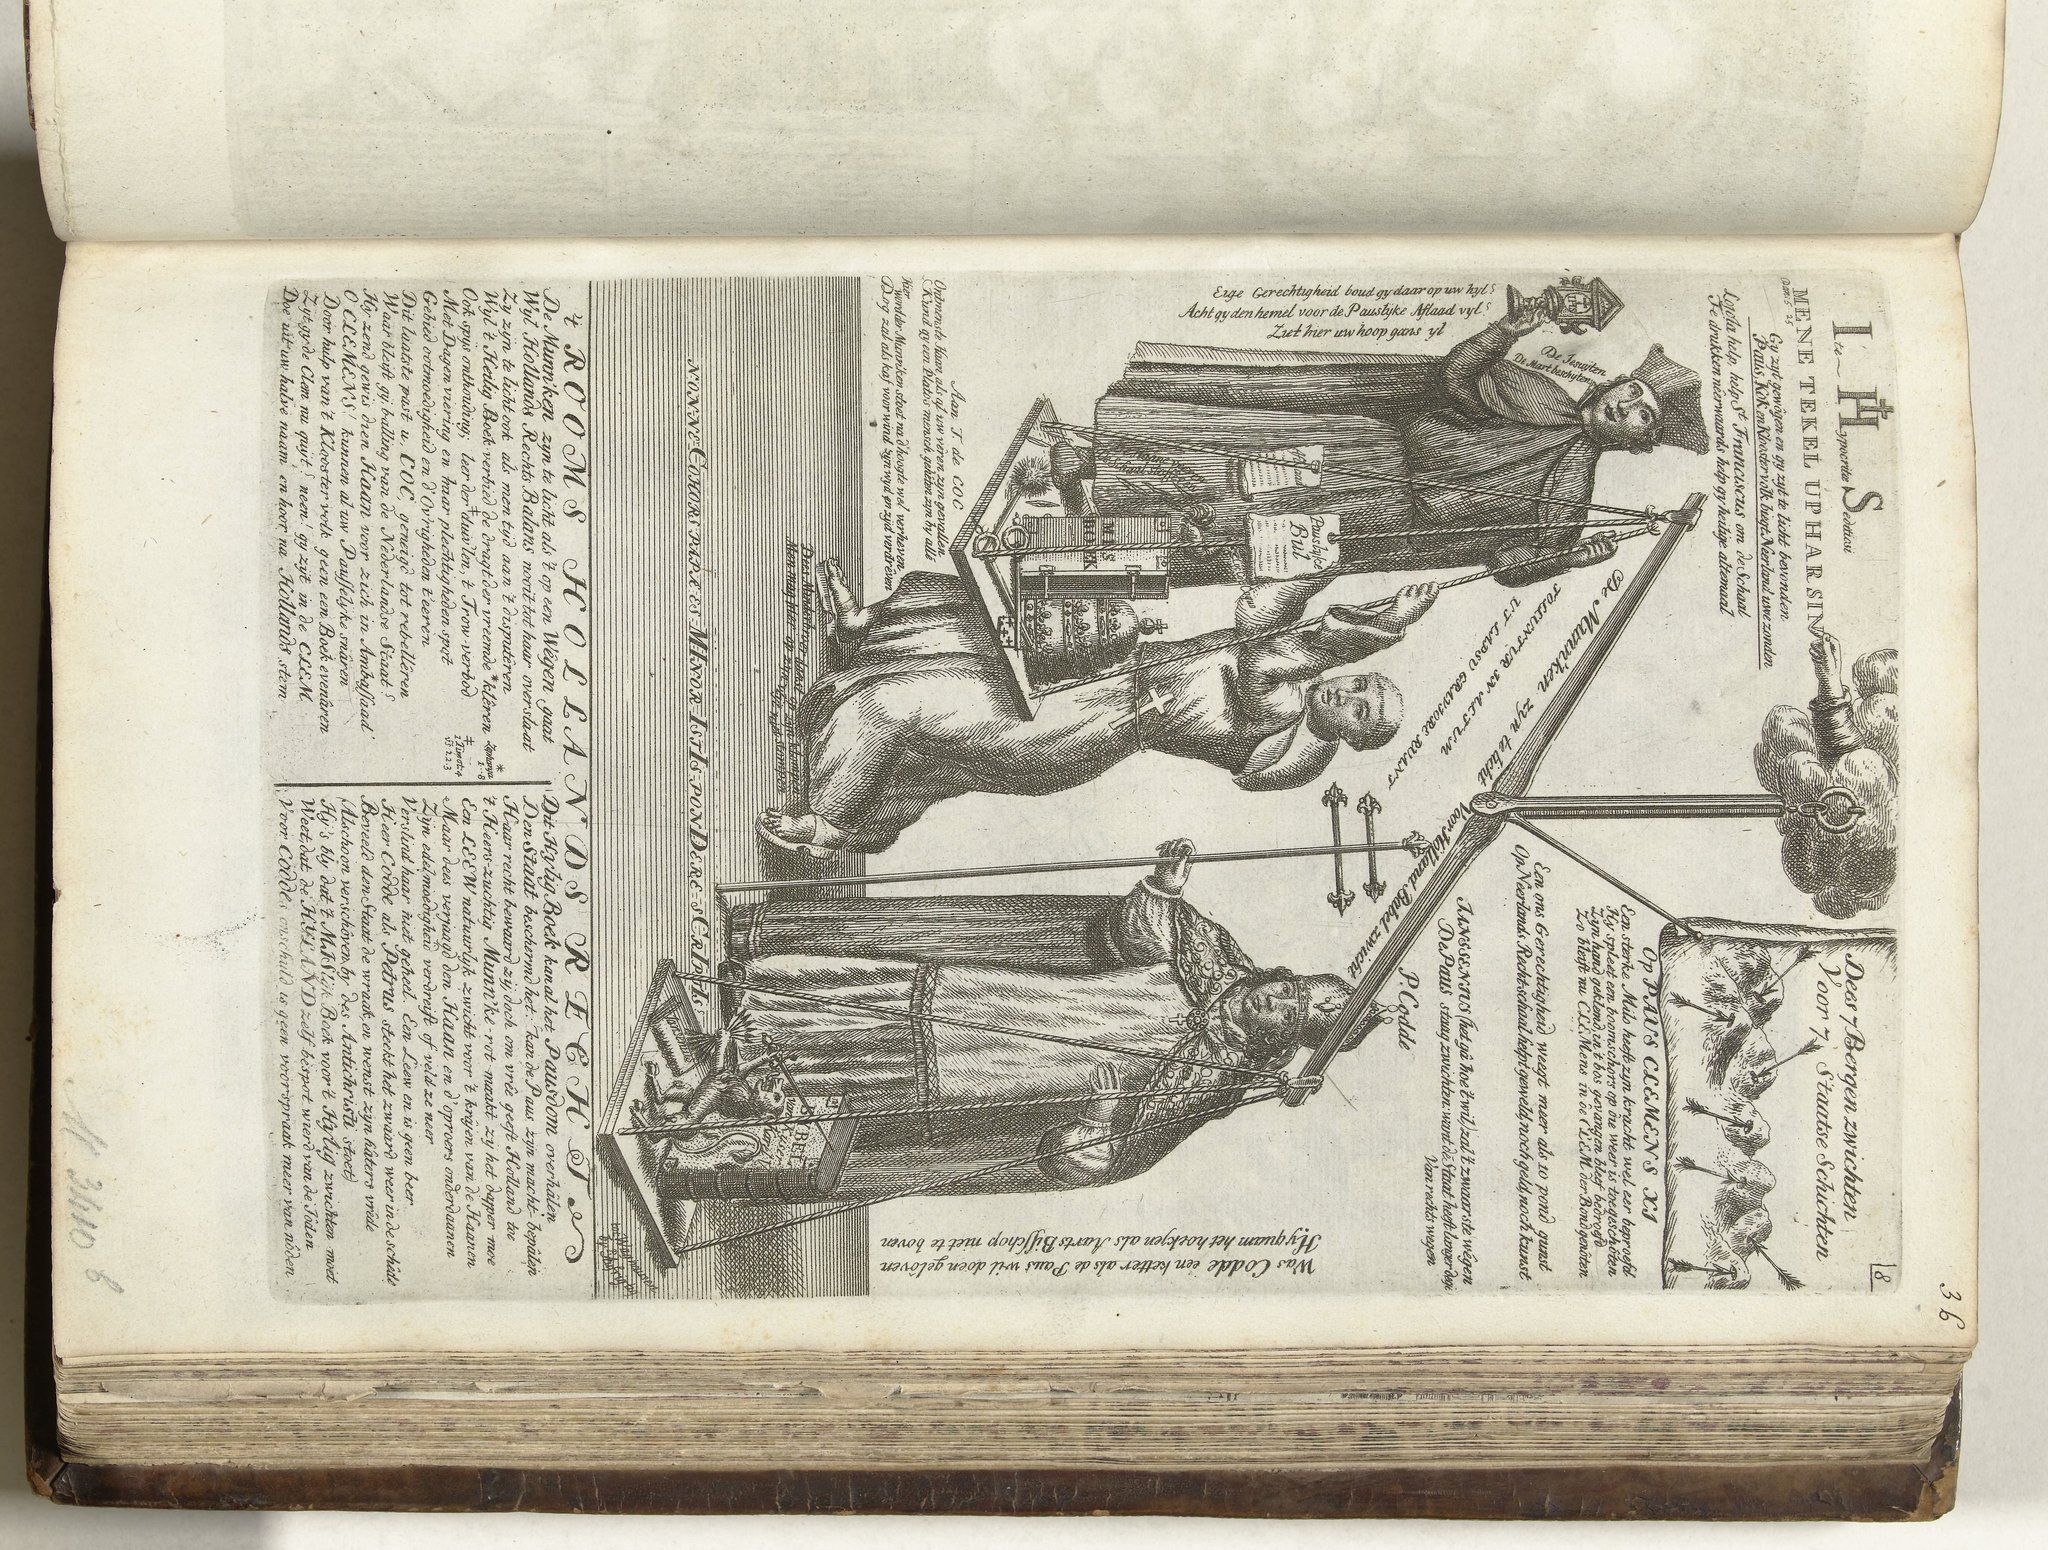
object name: print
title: Jansenisme gewogen tegen de jezuïet, 1705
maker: carel allard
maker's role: print maker, publisher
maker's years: 1648-1709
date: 1706-1707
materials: paper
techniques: etching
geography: amsterdam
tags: rome, amsterdam, utrecht, scales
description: Op een weegschaal in de hand van God wordt het boek van Jansenius, de bijbel en de Hollandse leeuw gewogen tegen een jezuïet met misboek en de symbolen van de paus. Hoewel een minderbroeder aan de schaal hangt slaat deze door naar de kant van het jansenisme. Hierbij staat Petrus Codde als aartsbisschop van Utrecht. Rechts boven de zeven heuvelen van Rome getroffen door de zeven pijlen van de Republiek. Blad nr. 8 in de serie van 13 bladen met spotprenten op de jezuïeten getiteld Roma Pertubata, 1707. Onderdeel van het prentwerk uitgegeven onder de verzameltitel 't Lust-Hof van Momus met de gebundelde series van spotprenten tijdens de jaren 1701-1713 van de Spaanse Successieoorlog.